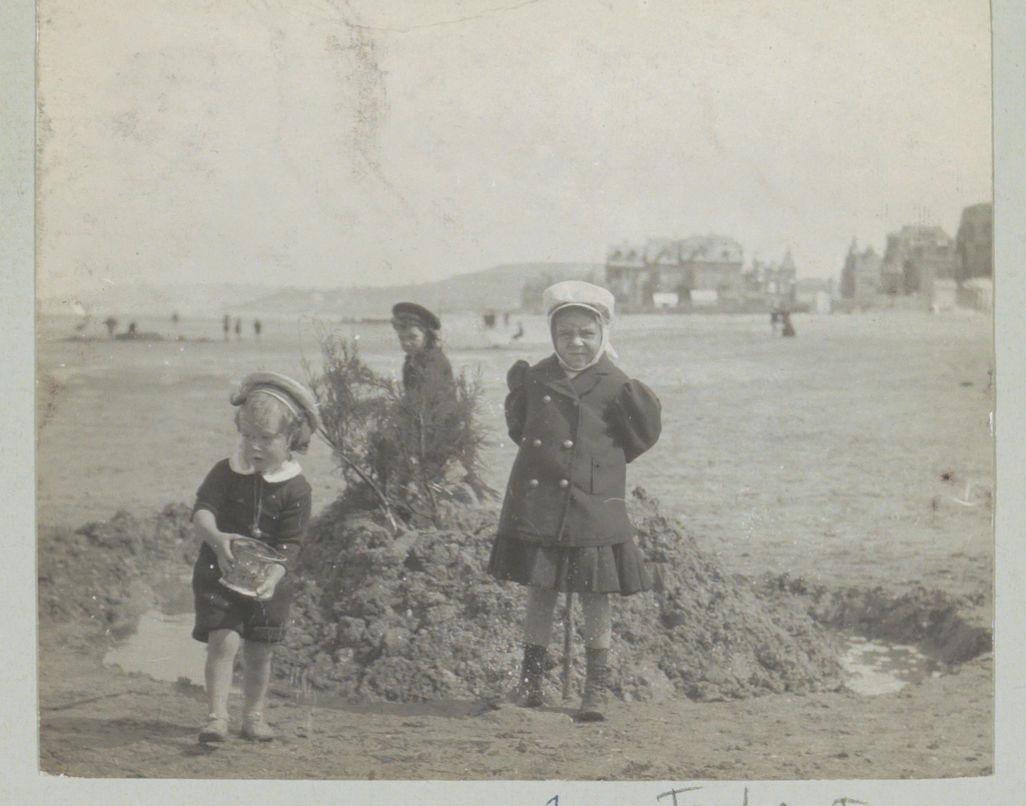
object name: photograph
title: Drie kinderen spelend bij een zandhoop aan het strand, vermoedelijk in Italië of Frankrijk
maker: Anonymous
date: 1905-1910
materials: paper, photographic support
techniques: matte daylight collodion silver print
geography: europe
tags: beach (as place of recreation), children's games and plays, europe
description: Onderdeel van Fotoalbum van een Franse amateurfotograaf met bezienswaardigheden in Frankrijk, Zwitserland en Italië.